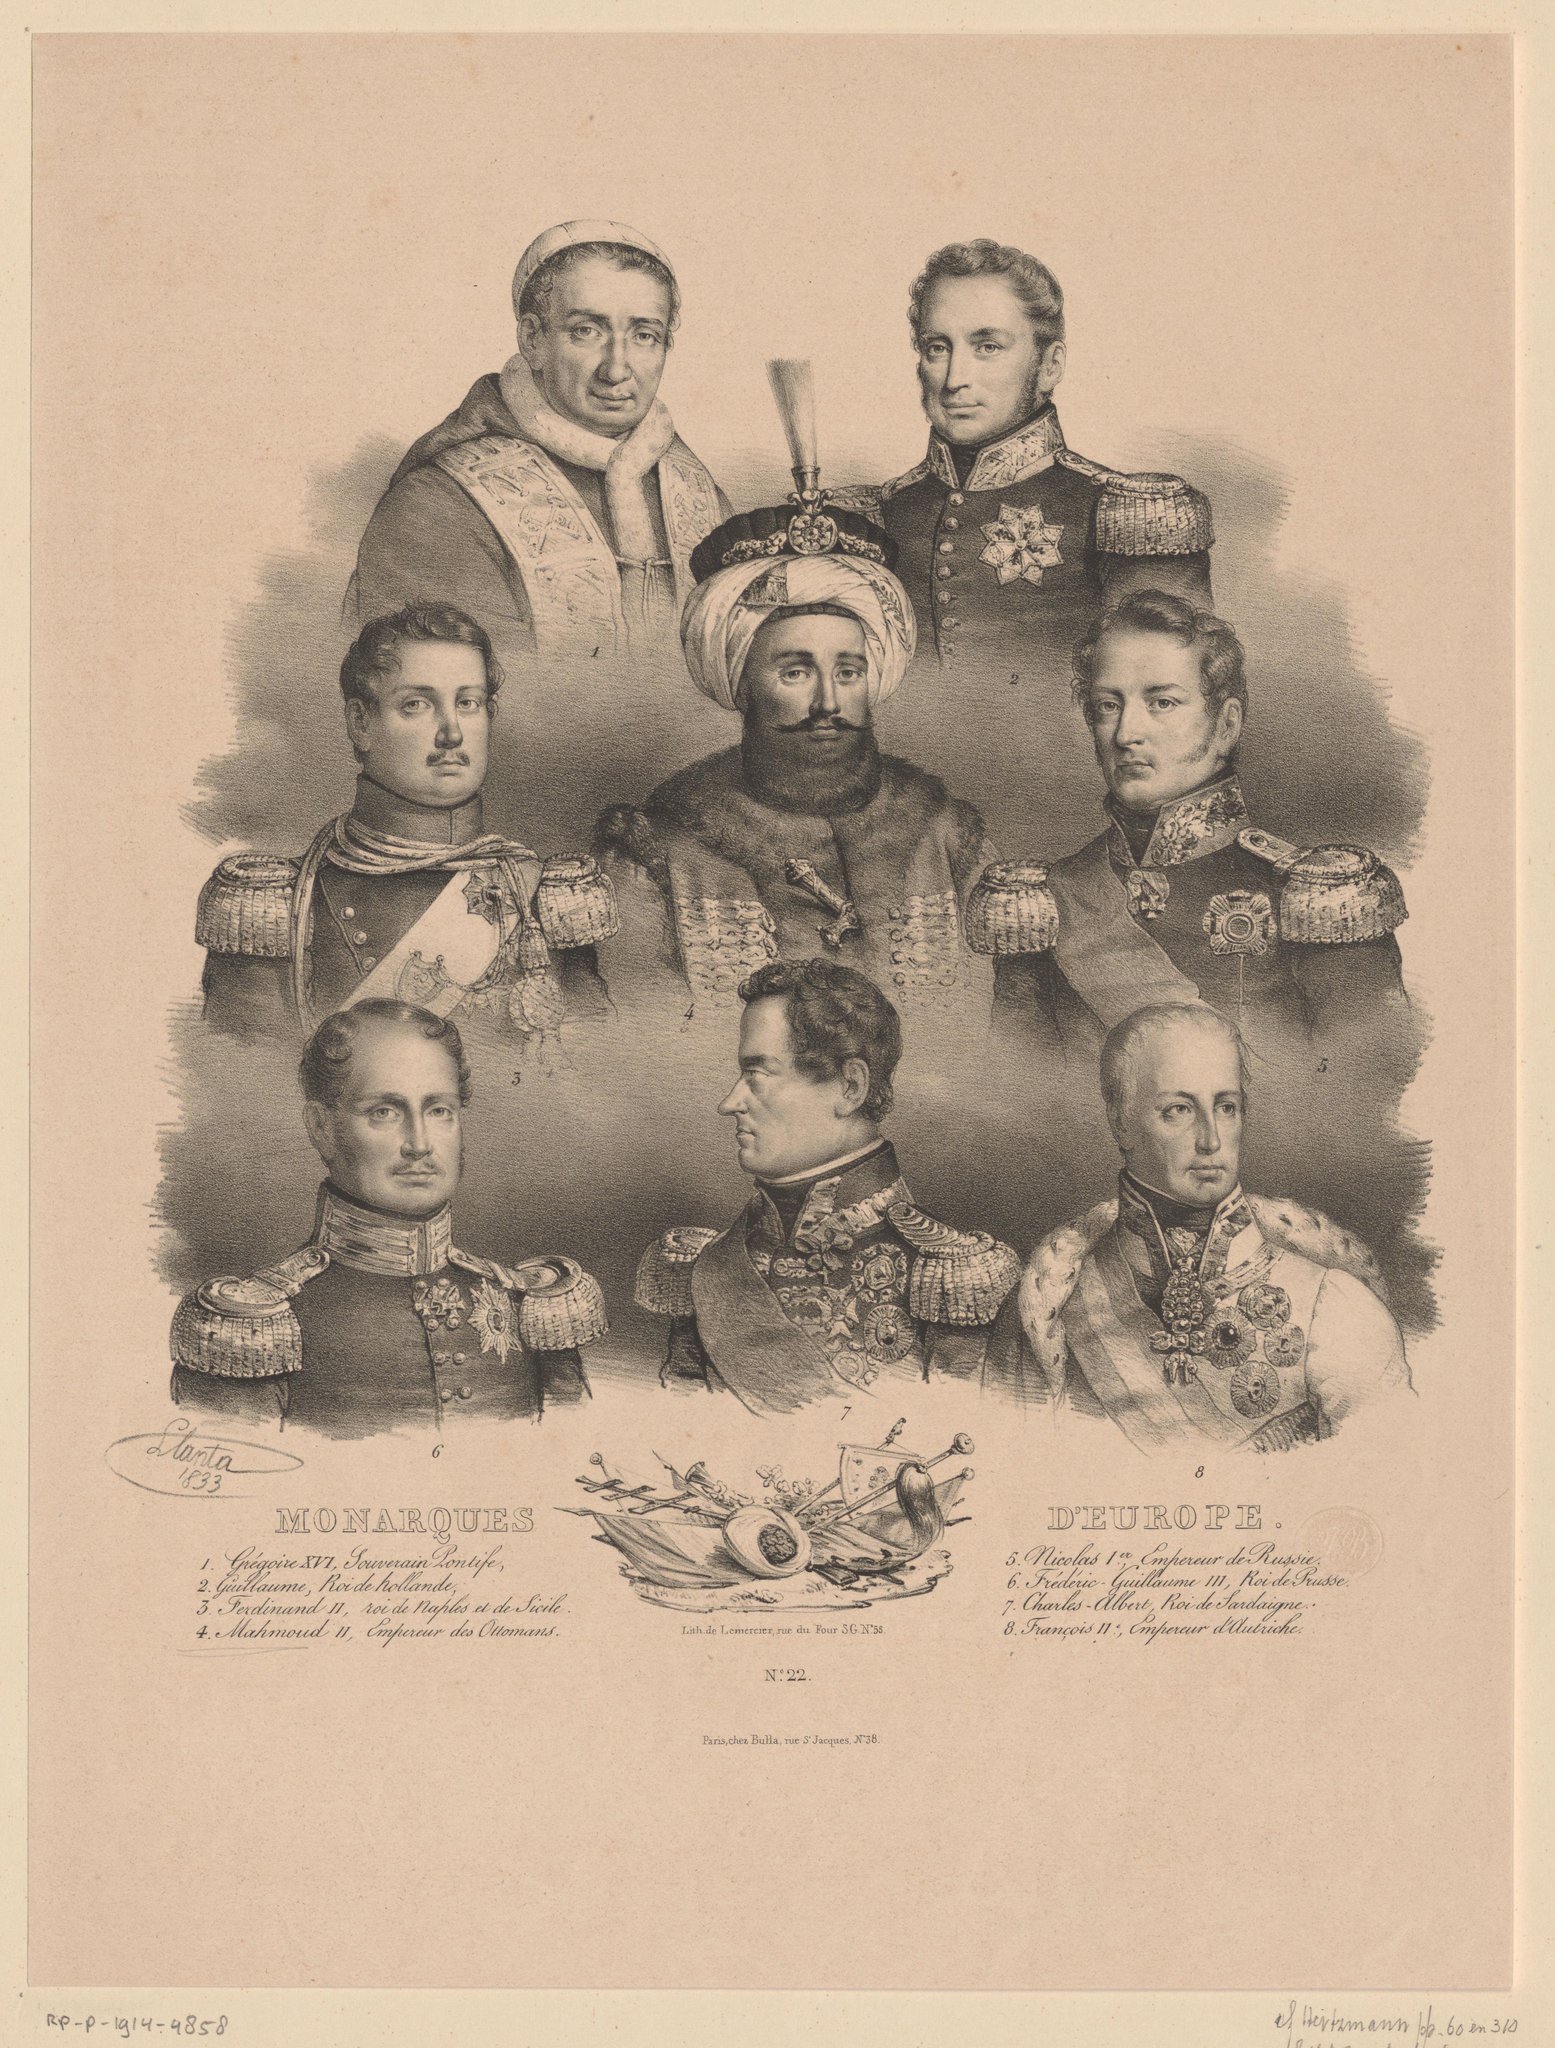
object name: print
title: Monarques d'Europe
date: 1833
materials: paper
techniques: lithograph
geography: paris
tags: rome, the hague, william i of the netherlands, caserta, vienna, frans ii (rooms-duits keizer), berlin, frederik willem iii koning van pruisen, historical persons, ruler, sovereign, pope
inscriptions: check stamp: Lugt 4088, collector's mark: Lugt 2228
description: Portretten van Europese vorsten met genummerde lijst: 1. Gregorius XVI, 2. Willem I (koning der Nederlanden), 3. Ferdinand II (koning der Beide Siciliën), 4. Mahmud II (sultan van het Ottomaanse Rijk), 5. Nicolaas I Pavlovitsj (tsaar van Rusland), 6. Frederik Willem III koning van Pruisen, Karel Albert (koning van Sardinië), Frans II (Rooms-Duits keizer). Midden onder genummerd: No. 22.